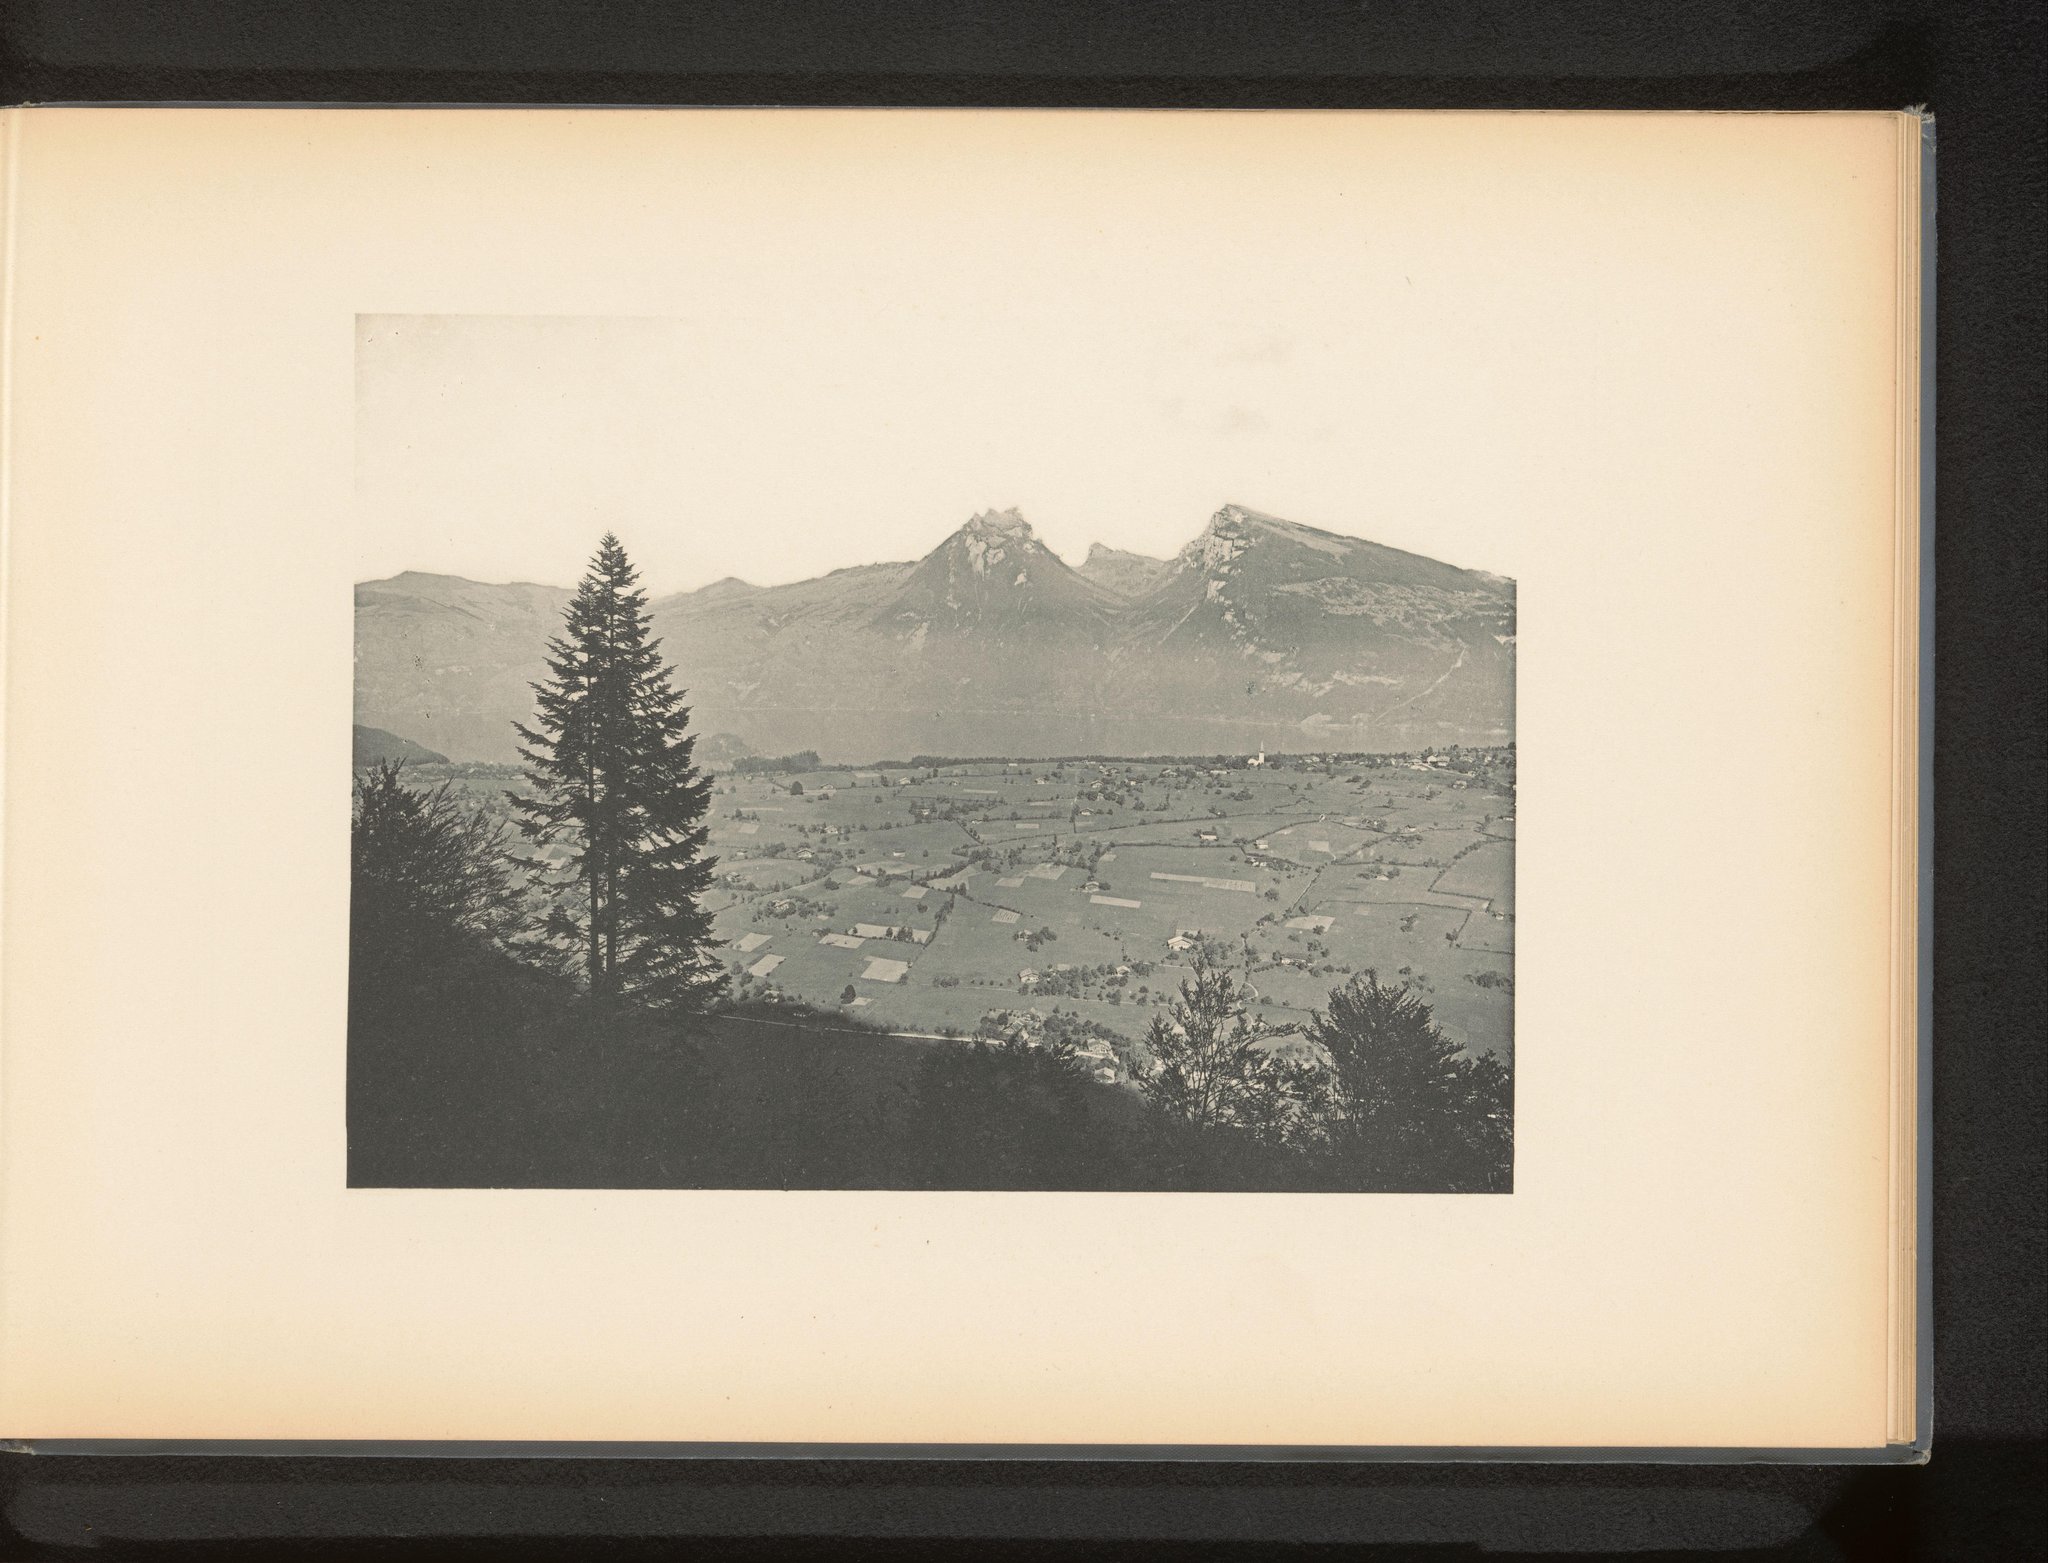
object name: photomechanical print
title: Gezicht op Aeschi bei Spiez, Zwitserland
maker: Anonymous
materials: paper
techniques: photograph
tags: prospect of village, silhouette of village, landscapes, mountains